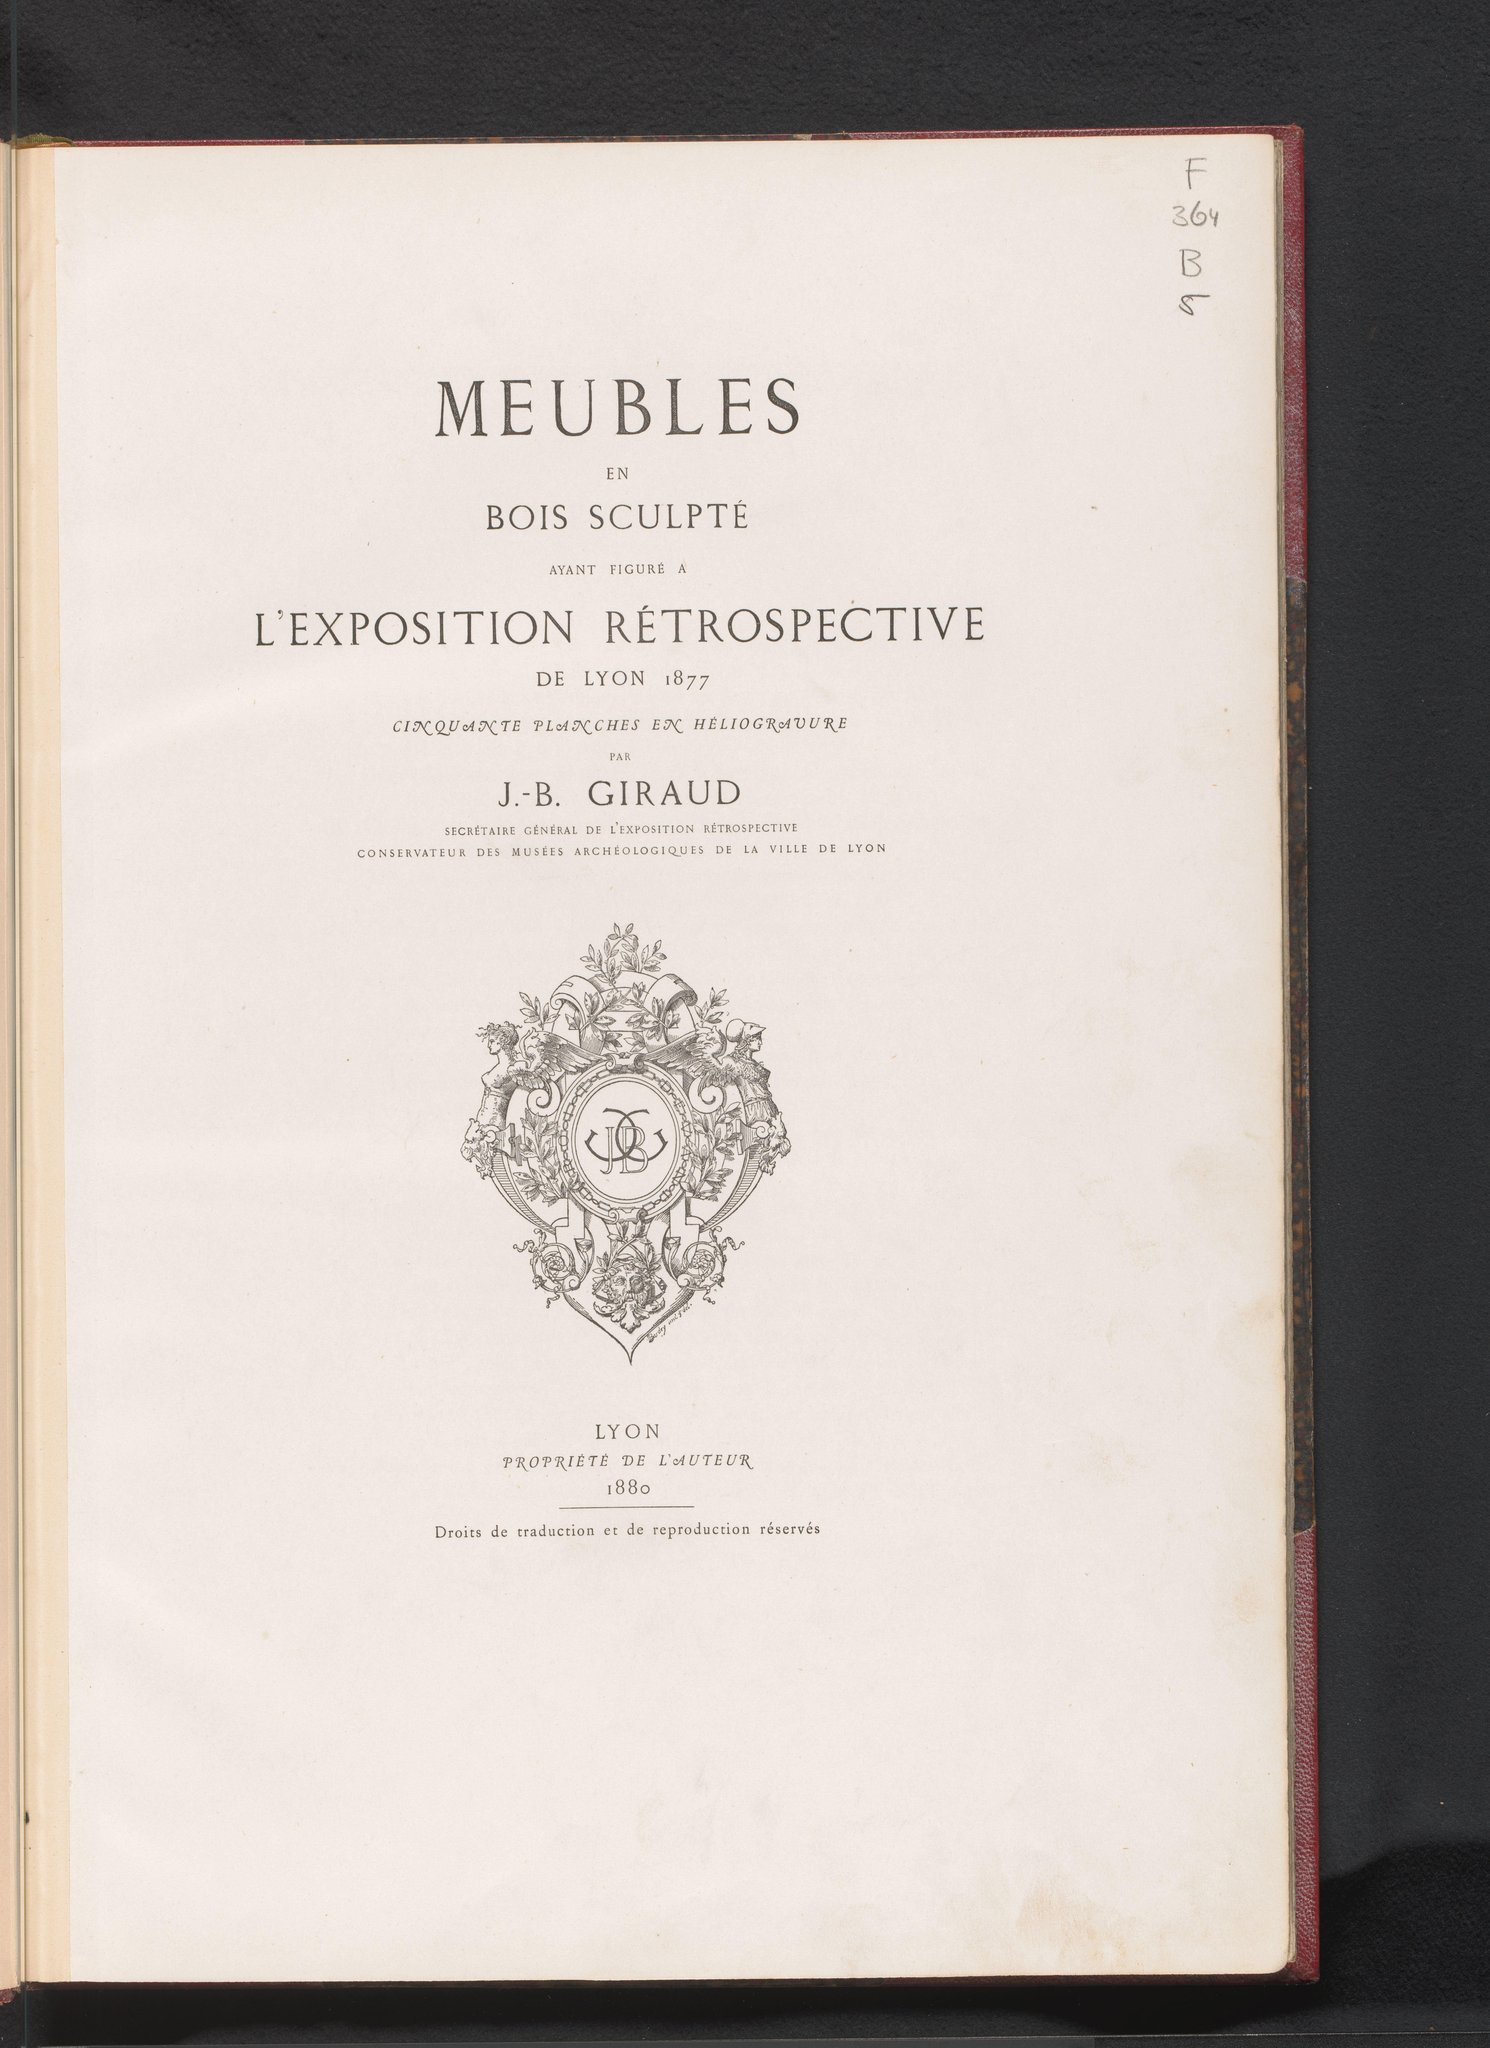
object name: book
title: Meubles en bois sculpté ayant figuré à l'exposition rétrospective de Lyon 1877 / cinquante planches en heliogravure par J.-B. Giraud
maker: jean-baptiste giraud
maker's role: schrijver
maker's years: 1844-1910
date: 1880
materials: cardboard, leather, linen, paper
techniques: marbled paper, photoaquatint, printing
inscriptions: date: ‘JAN/ 1989’